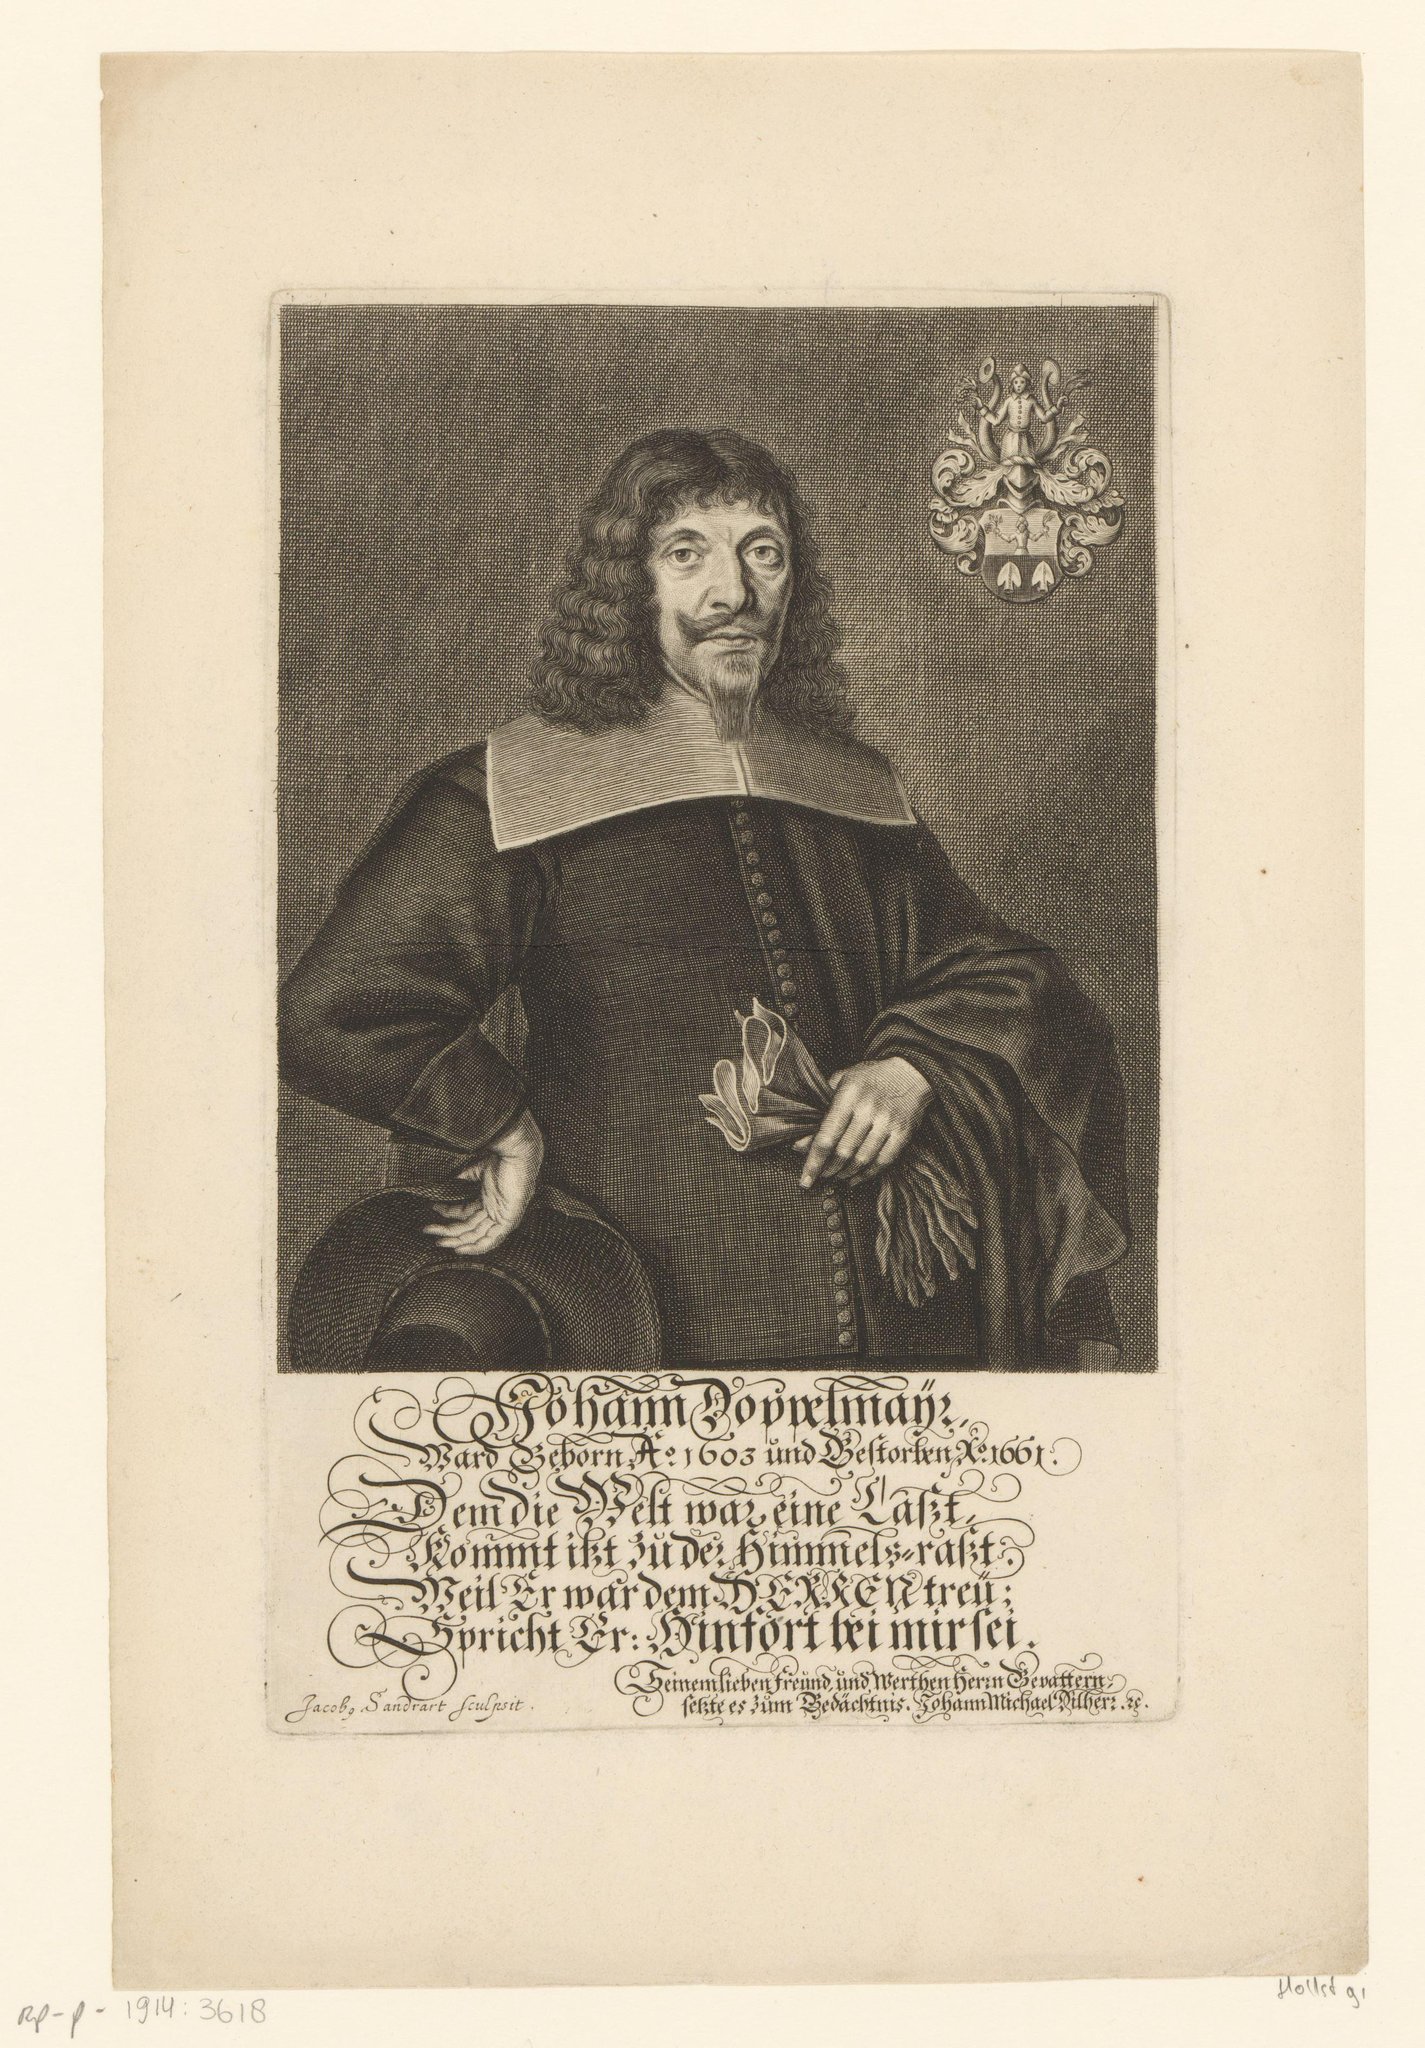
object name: print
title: Portret van Johann Doppelmayr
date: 1661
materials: paper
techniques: engraving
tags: historical persons, armorial bearing, heraldry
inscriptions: collector's mark: Lugt 2228